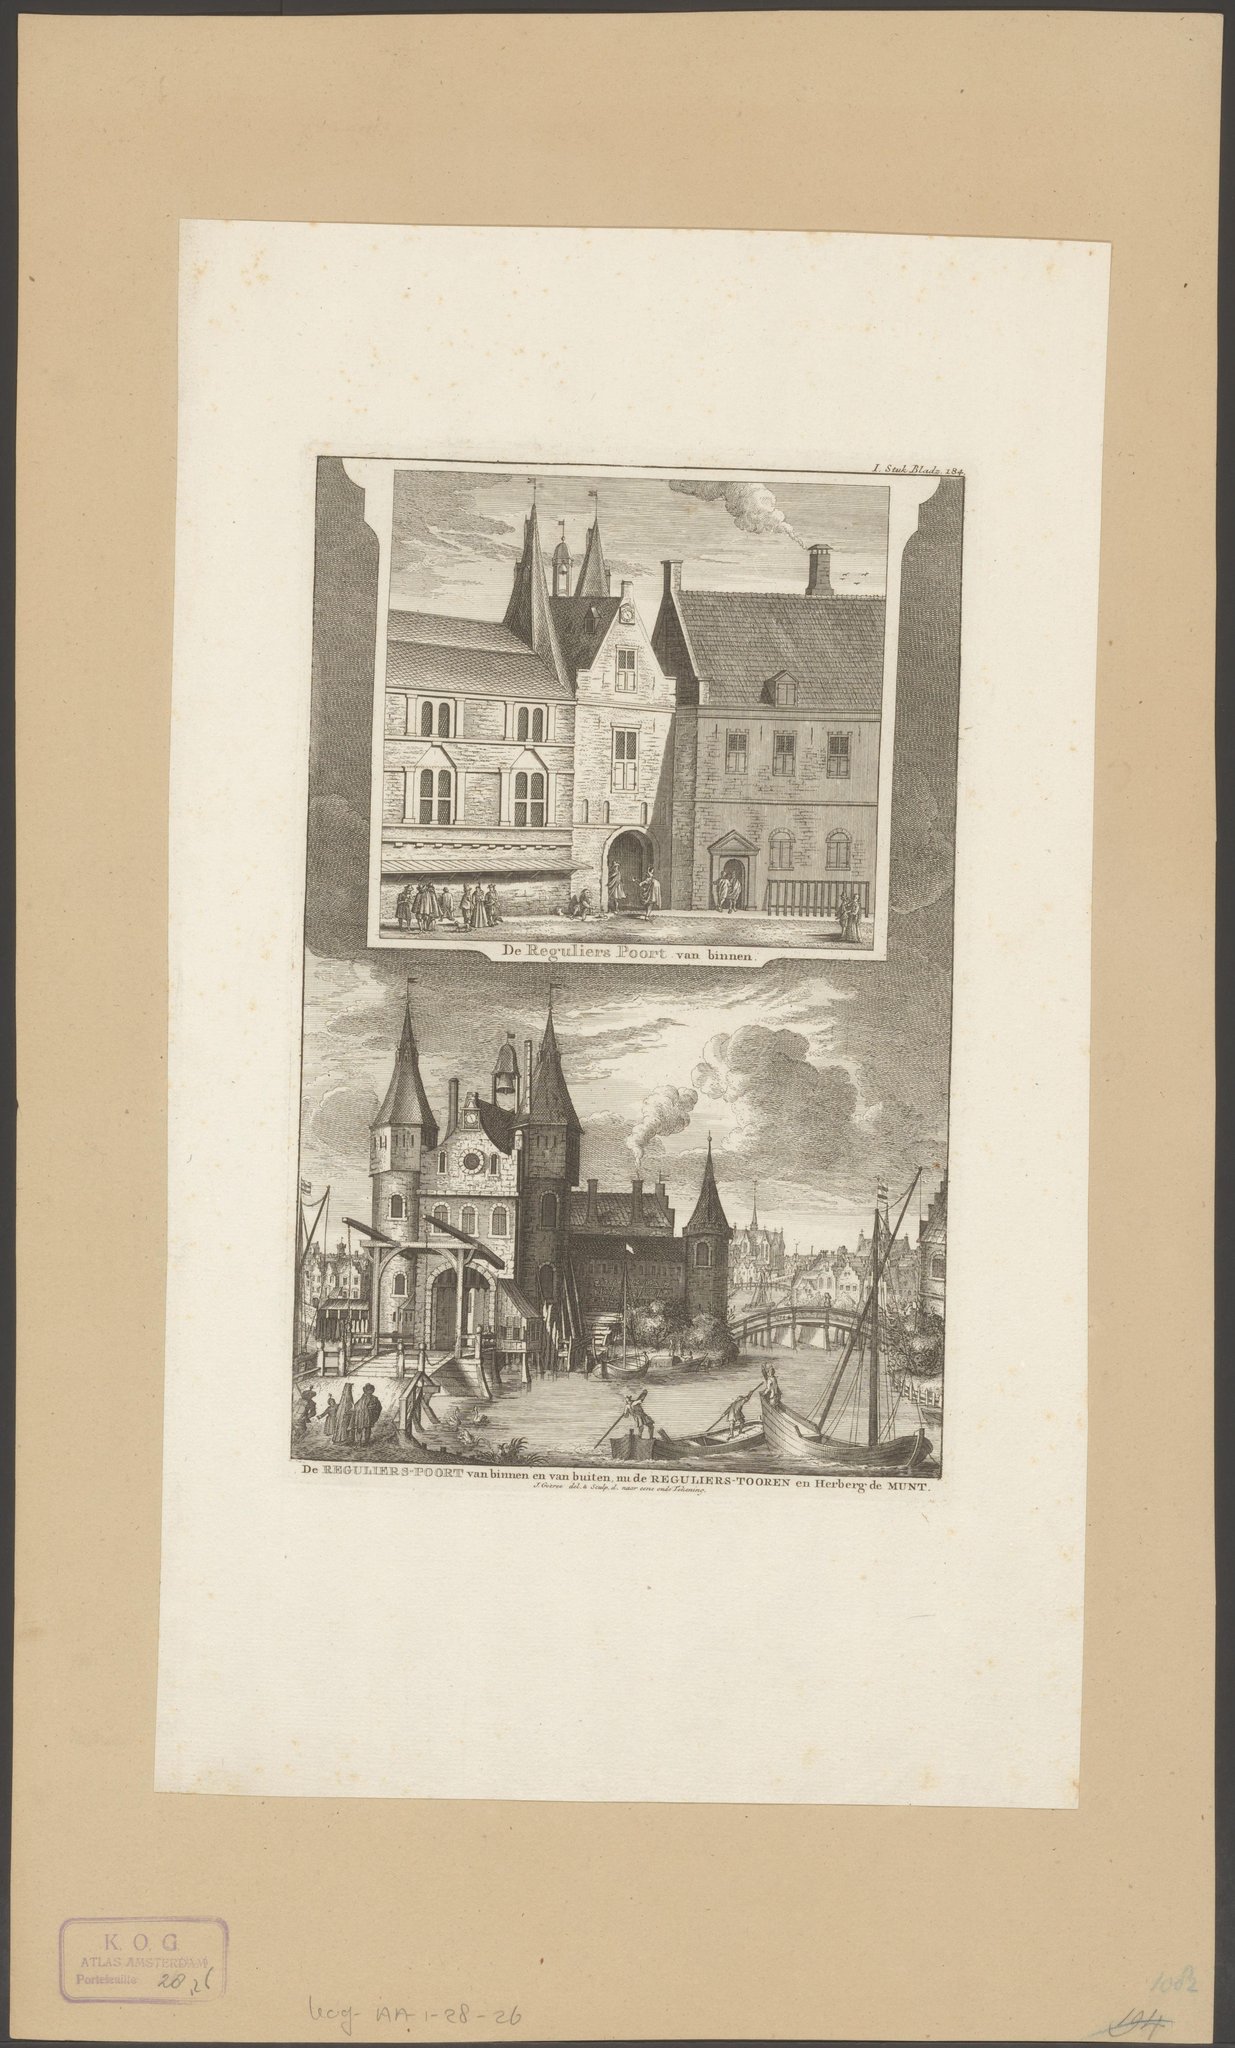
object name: book illustration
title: De Reguliers Poort van binnen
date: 1680-1782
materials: paper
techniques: engraving, etching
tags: bridge, city-gate, city-walls (+ city(-scape) with figures, staffage)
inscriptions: collector's mark: Lugt 1641b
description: Prent mogelijk uit: Wagenaar, Jan. Amsterdam in zyne opkomst, aanwas, geschiedenissen, voorregten, koophandel (...). Amsterdam: Isaak Tirion, 1760. Of uit: Verzameling der fraaiste Gezigten van Amsterdam in negenenzeventig afbeeldingen. Amsterdam: Petrus Conrad, Harlingen: Volkert van der Plaats, 1782.